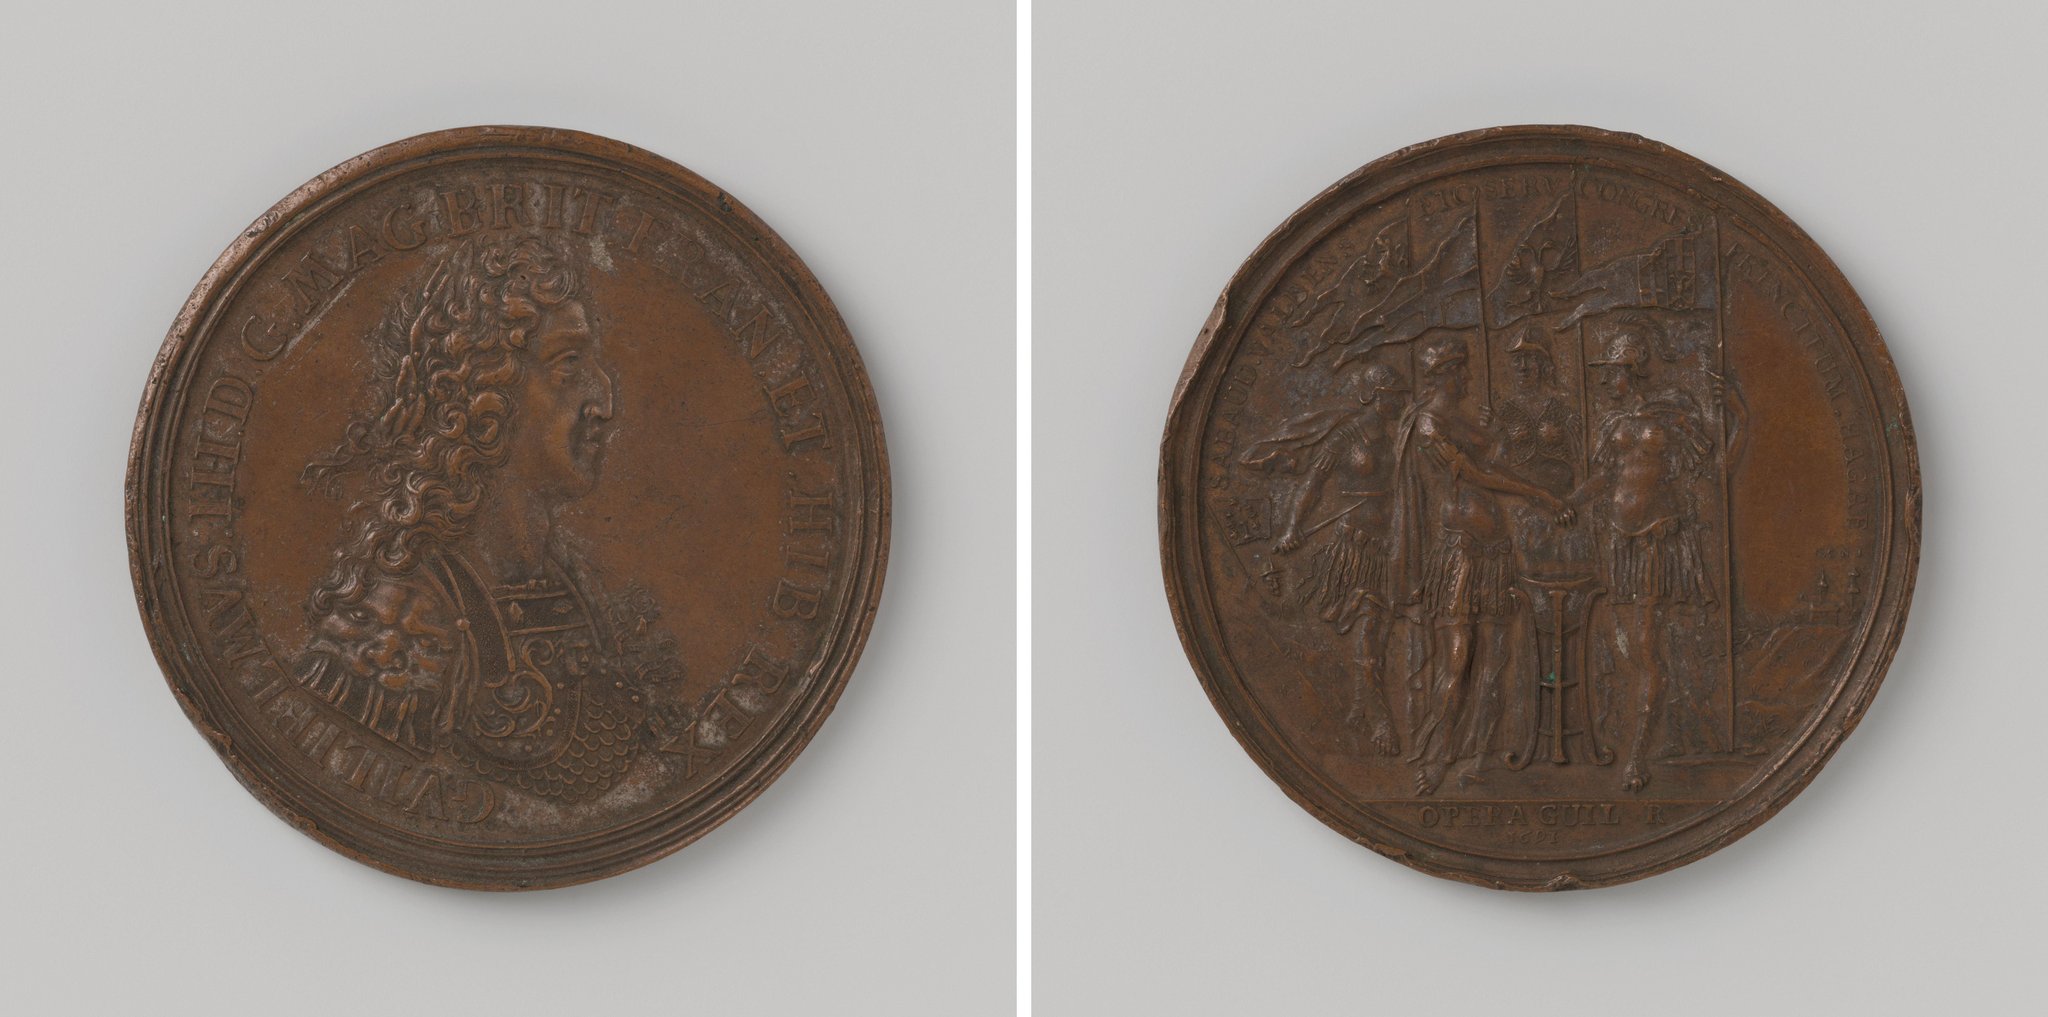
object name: copy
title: Ontzet van Coni, ter ere van Willem III, leider van het congres van 's-Gravenhage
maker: jan luder (i)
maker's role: medailleur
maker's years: 1648-1719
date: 1691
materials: bronze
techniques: striking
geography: amsterdam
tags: william iii (prince of orange and king of england, scotland, and ireland), paris, vienna, eugenius van savoye